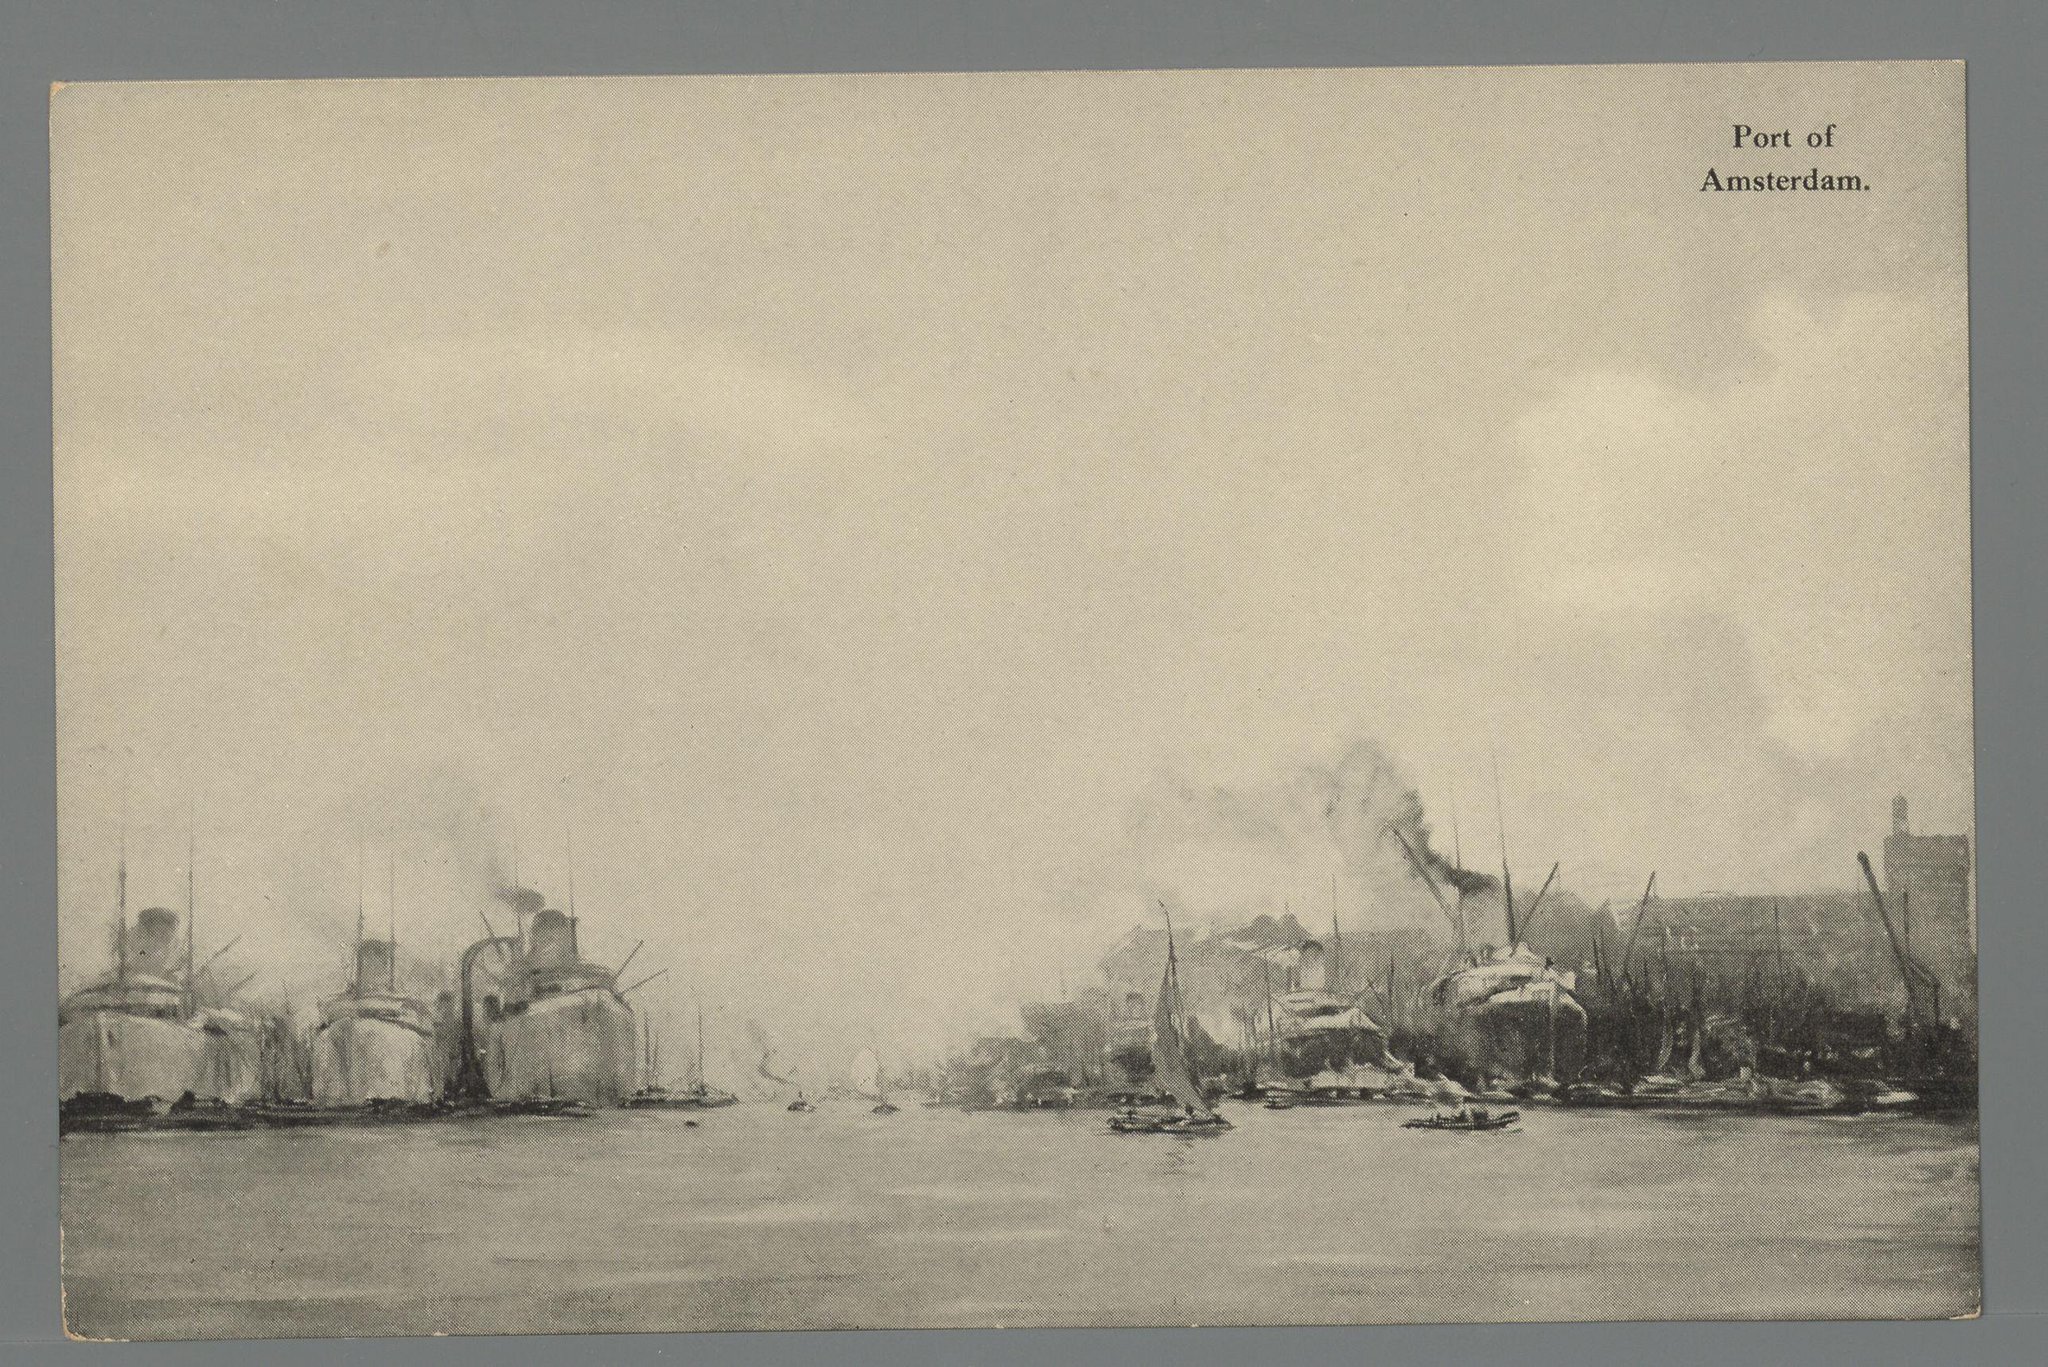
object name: ansichtkaart, prentbriefkaart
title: Reproductie van: Port of Amsterdam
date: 1912-1930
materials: cardboard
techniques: autotype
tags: harbour, sailing-ship, sailing-boat, steamship, motorship, port of amsterdam